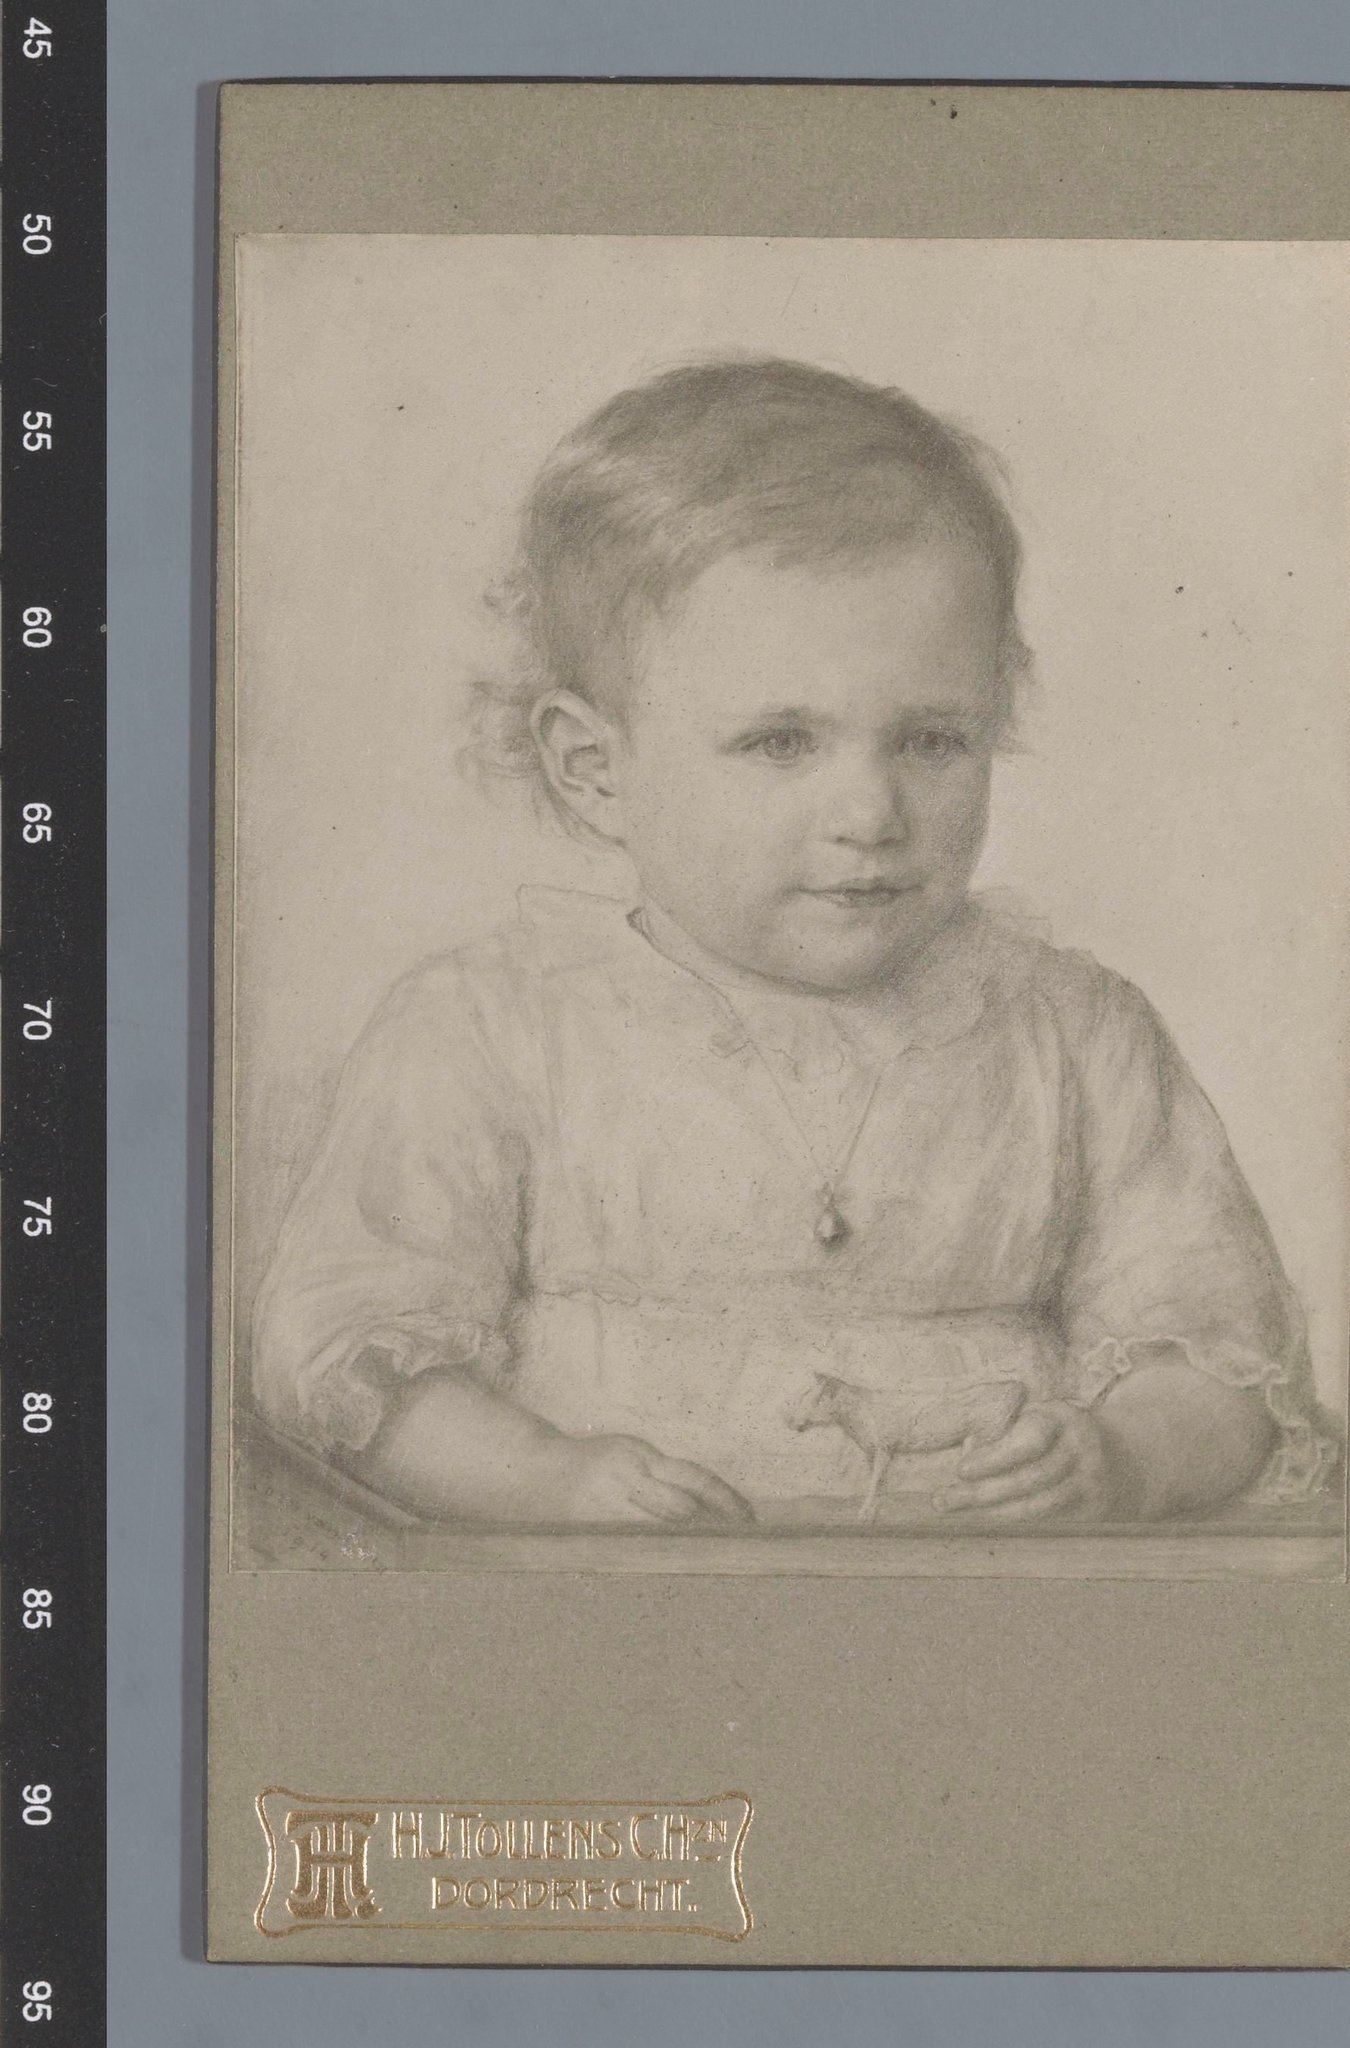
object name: carte de visite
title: Fotoreproductie van een tekening door Coen van Oven, voorstellend Anne Marie Langelaan als kind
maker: henricus jacobus tollens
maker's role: painter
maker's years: 1864-1936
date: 1888-1905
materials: cardboard, paper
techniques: carbon print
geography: dordrecht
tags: drawing, sketch, child (at home)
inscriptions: inscription: ‘Anne Marie Langelaan 1 1/2 jaar oud. Naar tekening van Coen van Oven’, inscription, name: ‘H.J. Tollens C.H zn Doredrecht.’